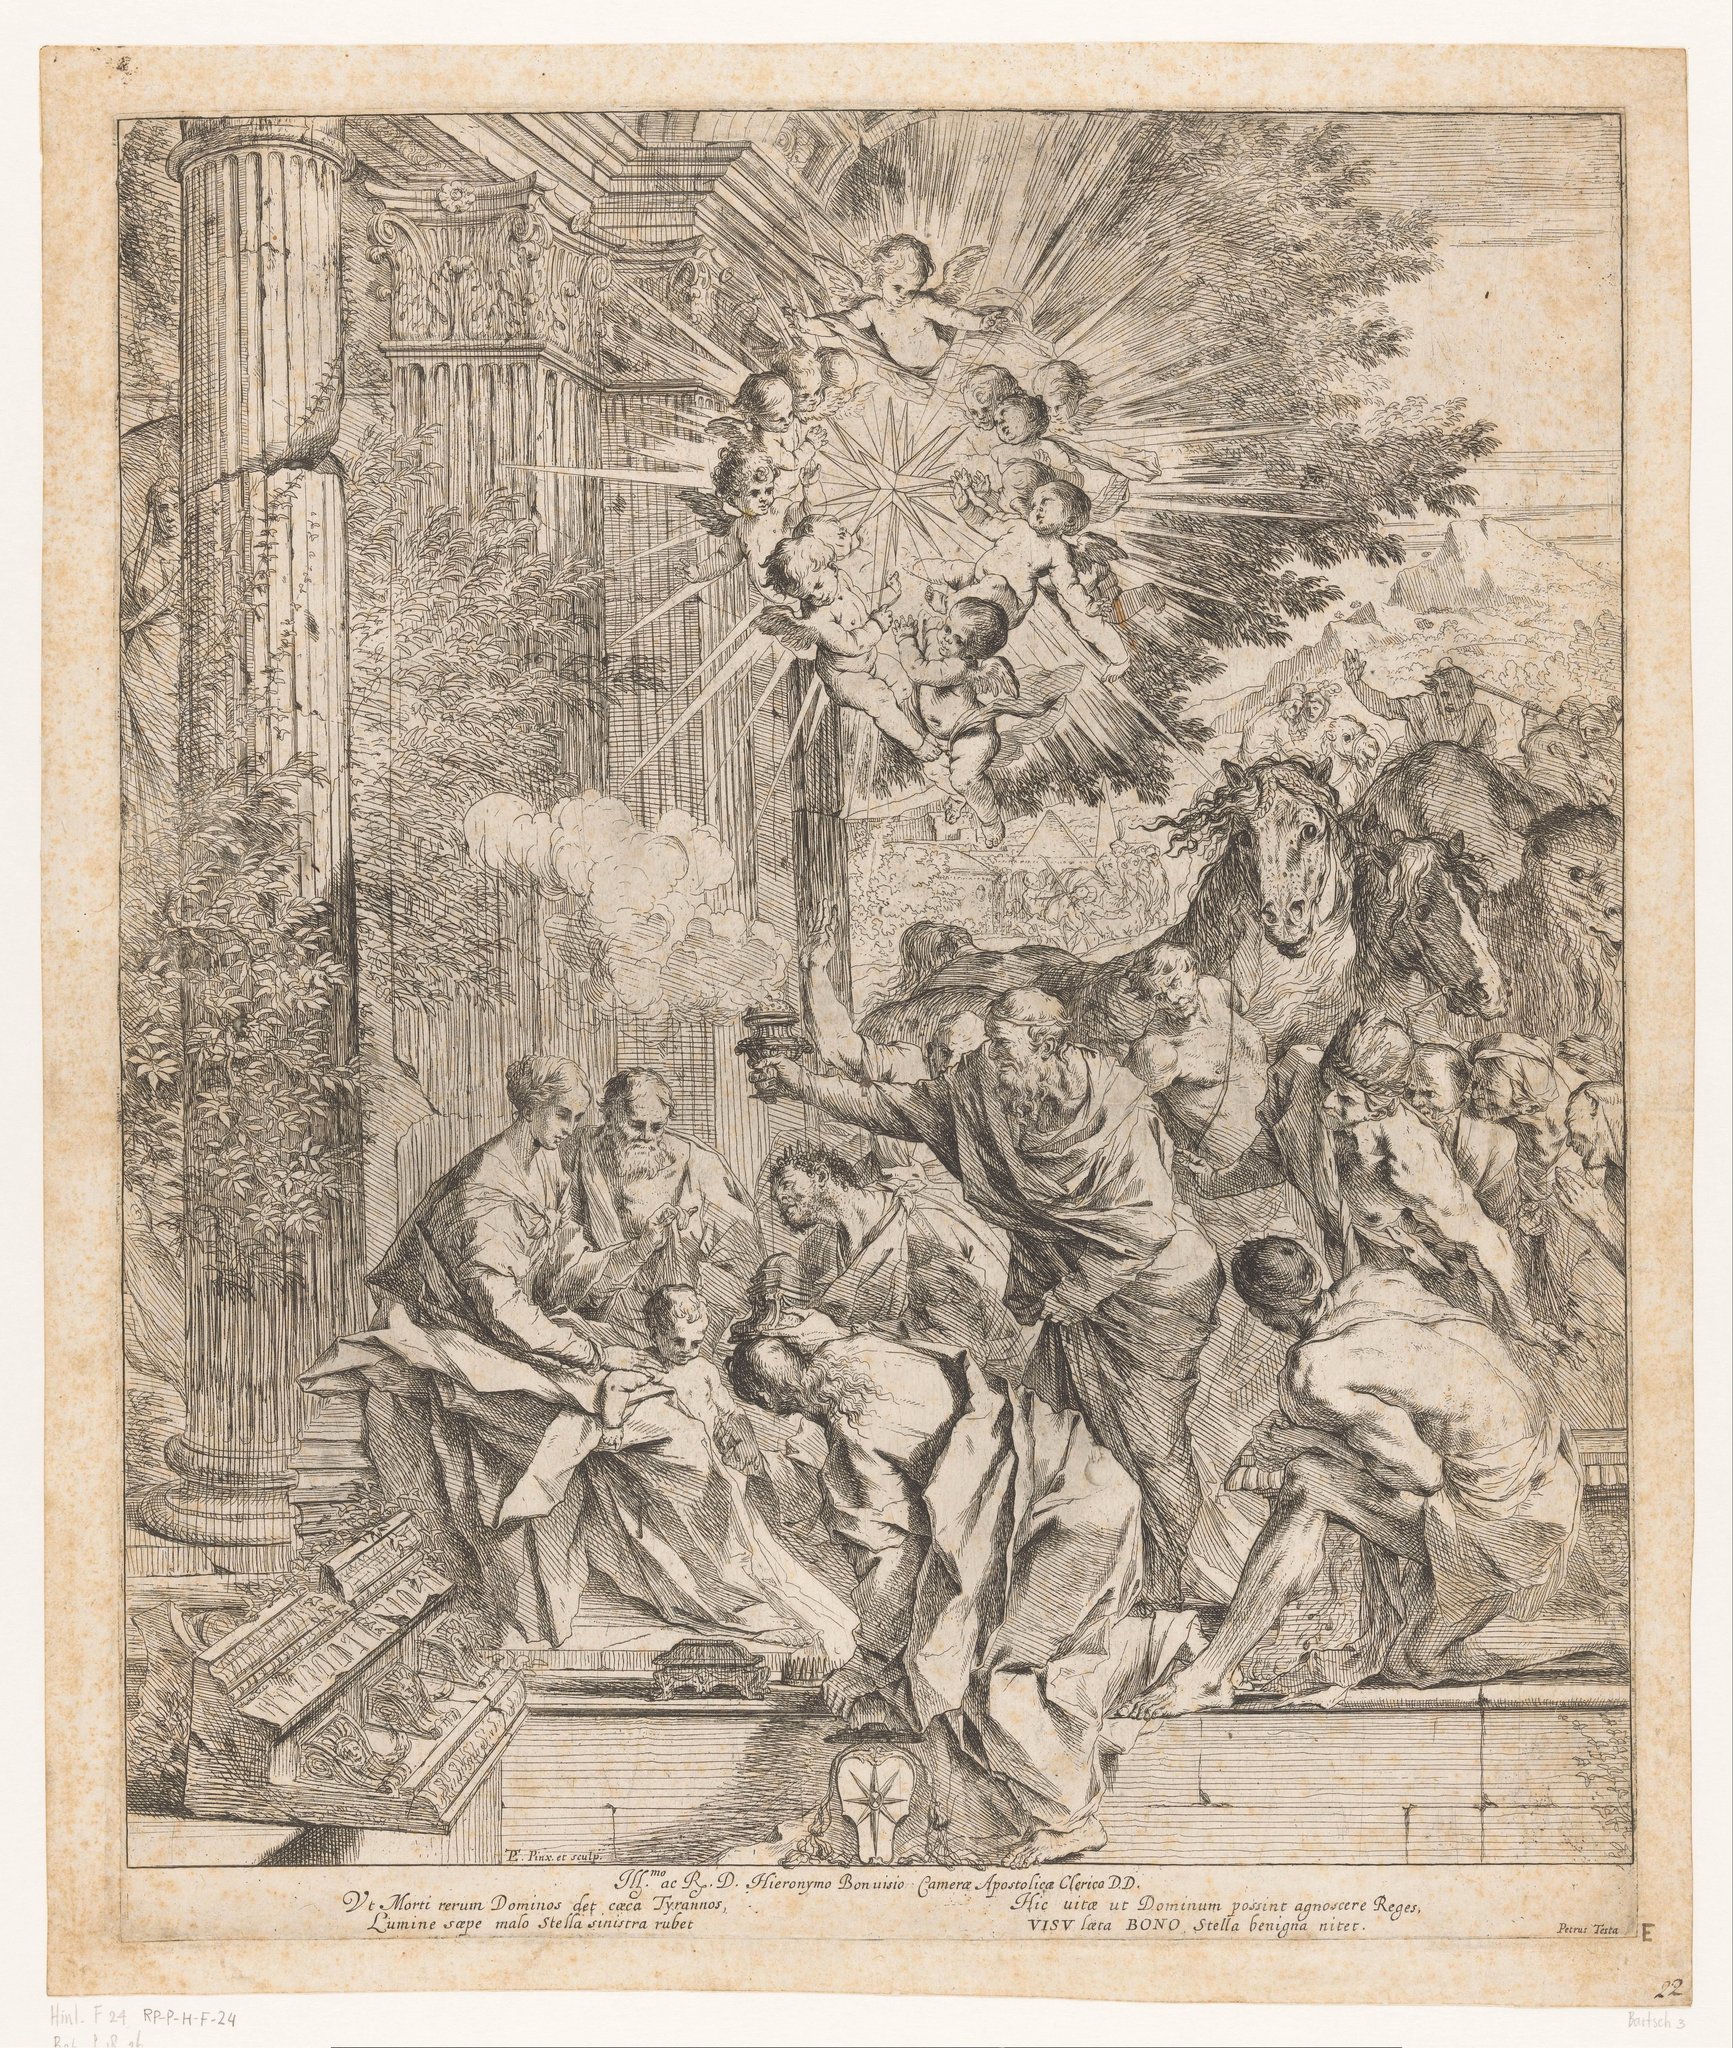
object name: print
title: Aanbidding door de koningen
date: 1636-1638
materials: paper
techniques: etching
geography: italy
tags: colonnade, adoration of the kings: the wise men present their gifts to the christ-child (gold, frankincense and myrrh), angels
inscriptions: collector's mark: Lugt 11, inscription: ‘E’, number: ‘22’, collector's mark: ‘Hinloopen’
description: Links de Heilige Familie, zittend voor een colonnade. De drie koningen aanbidden het Christuskind en tonen de meegebrachte geschenken. Rechts het gevolg van de drie koningen. In de lucht wordt een ster gedragen door een groep engelen. Opdracht en twee kolommen Latijnse tekst in ondermarge.